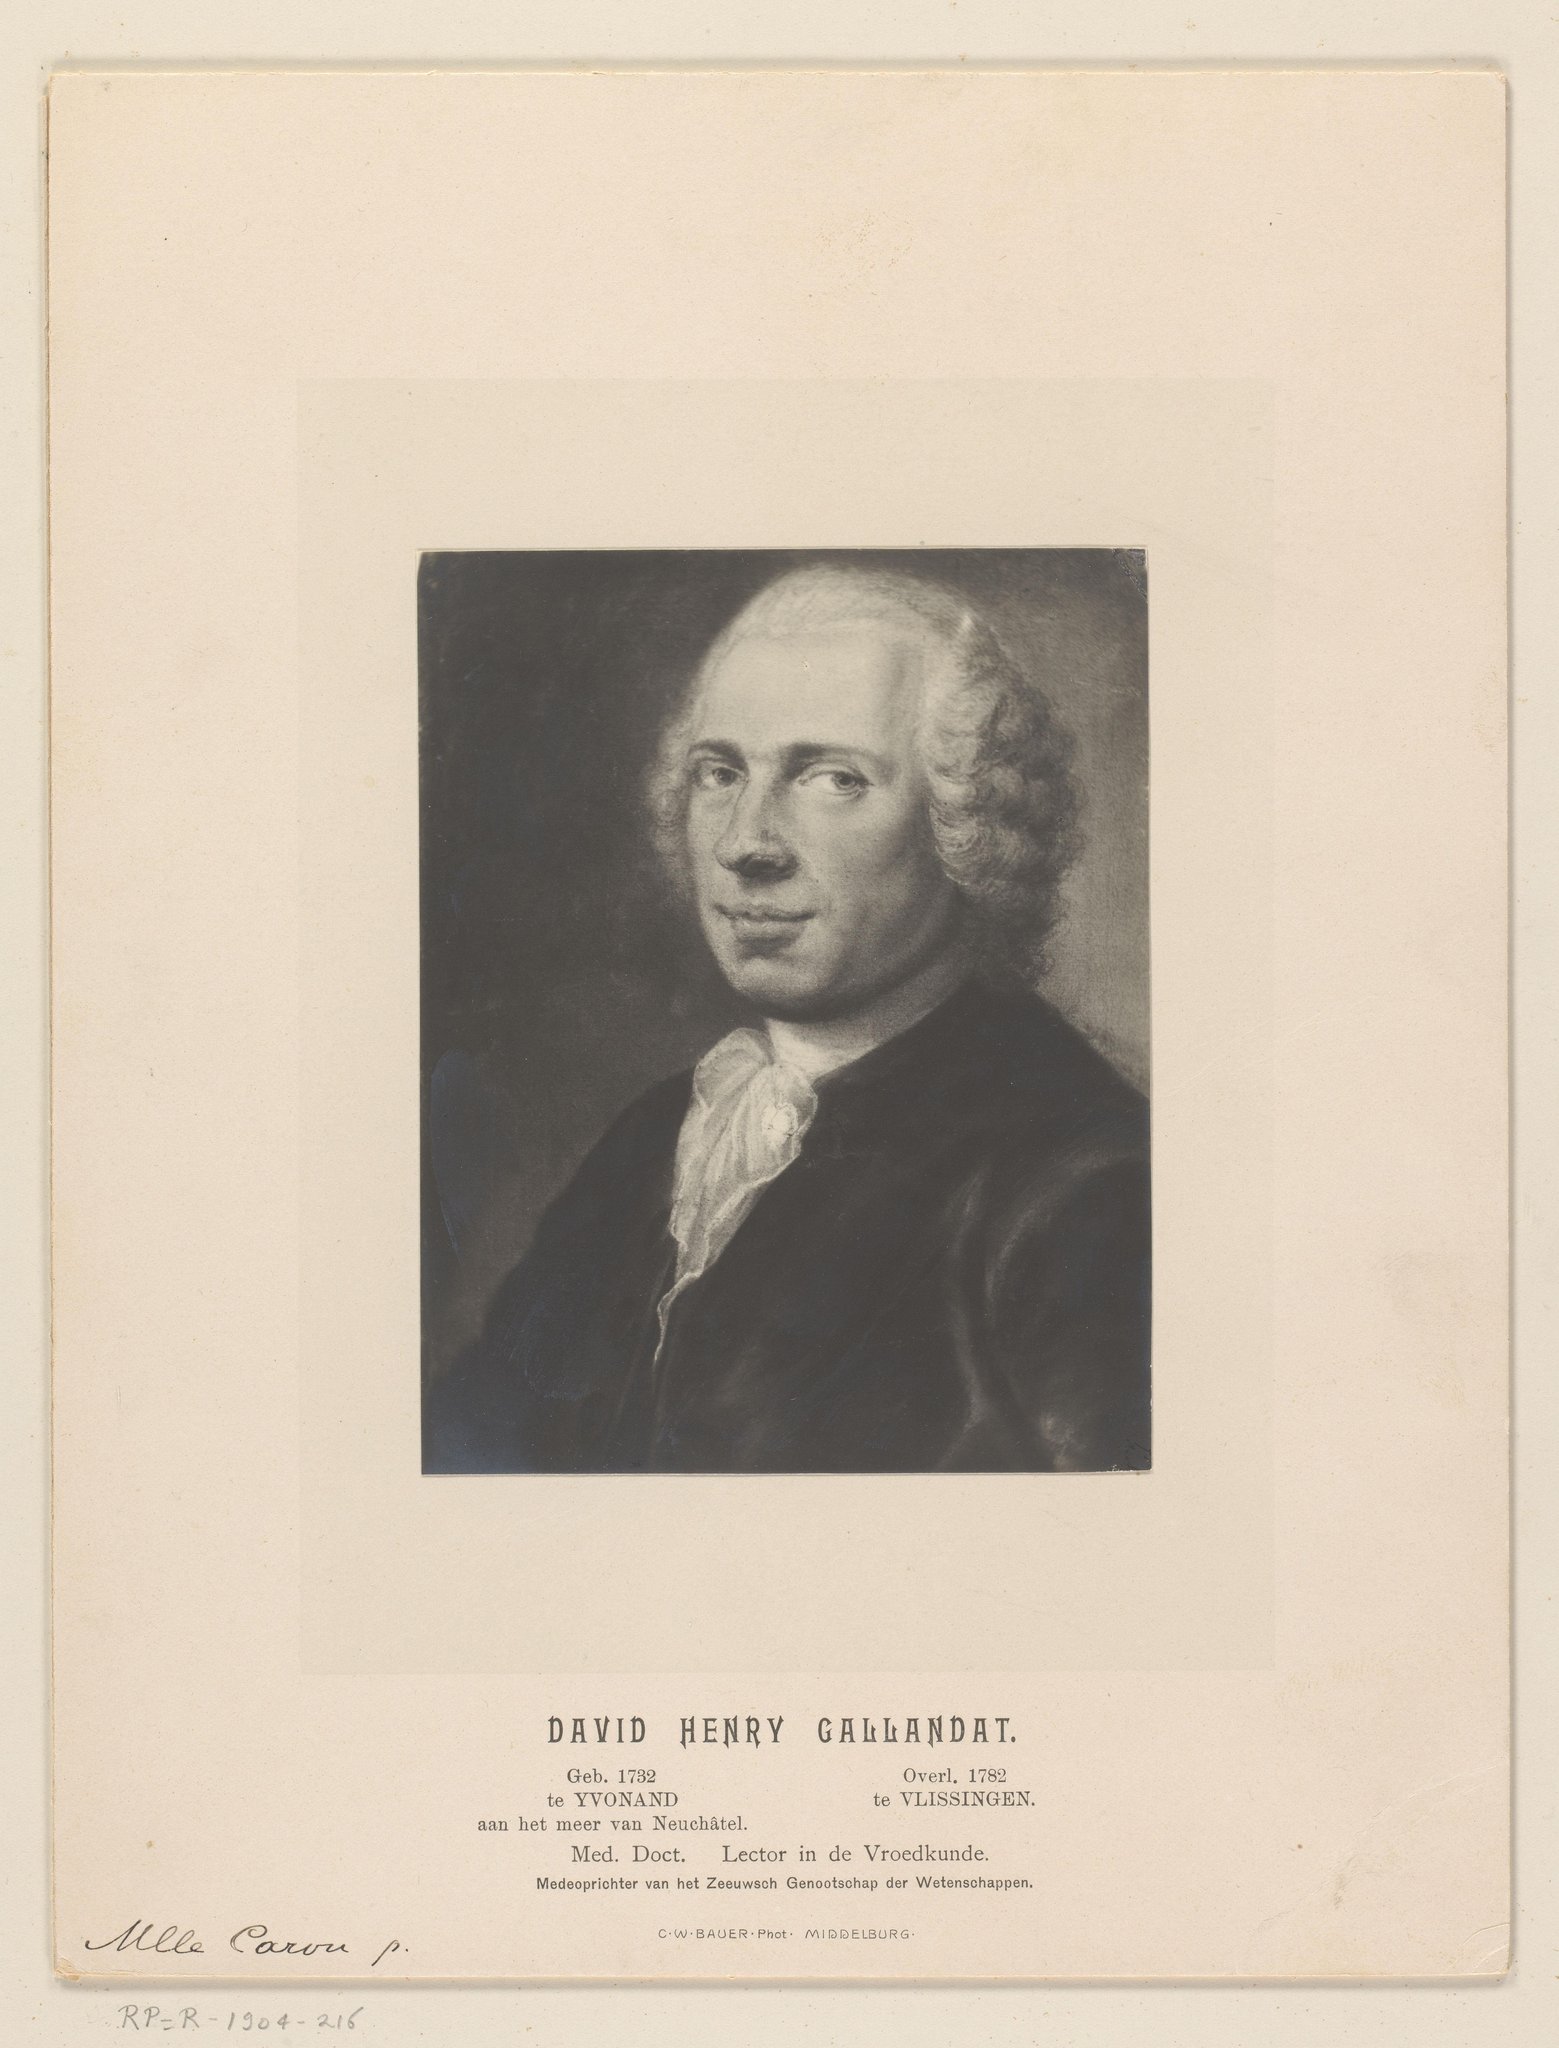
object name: photograph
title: Fotoreproductie van een getekend portret van David Henry Gallandat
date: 1885-1904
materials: paper, cardboard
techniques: gelatin silver print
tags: flushing, historical persons, physician, doctor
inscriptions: inscription: ‘Mlle Caron p.’, collector's mark: Lugt 2228a, inscription: ‘Het pastel portret (...) deed ook/ Gallandat.’